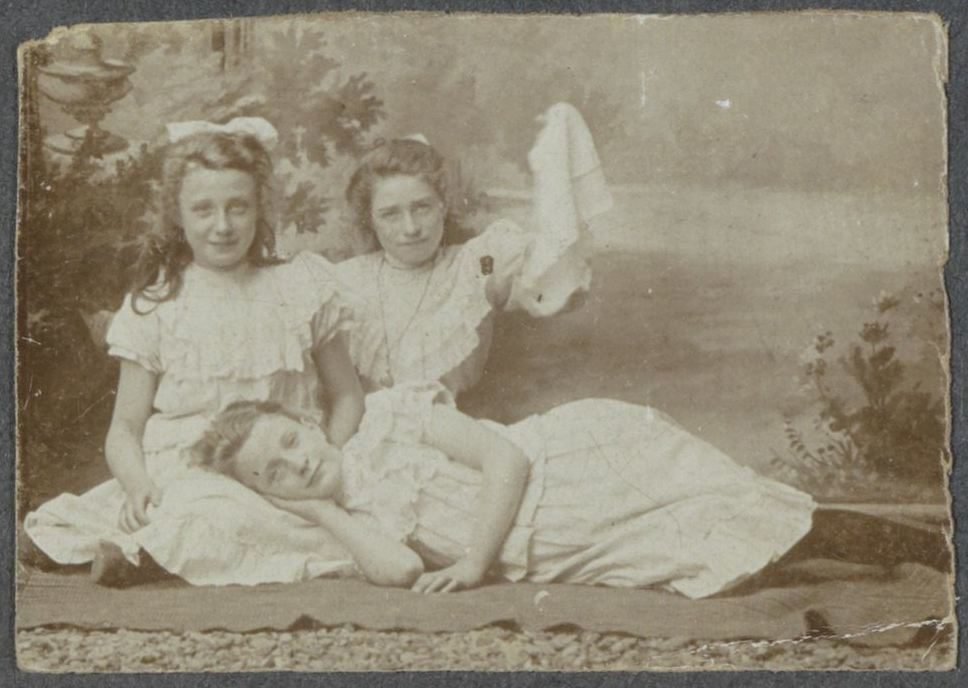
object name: photograph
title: Groepsportret van drie meisjes, mogelijk zussen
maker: Anonymous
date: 1920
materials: cardboard, paper, photographic support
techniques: collodion silver print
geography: netherlands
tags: studio requisites ~ photographer, historical persons, sisters (second degree family relationships), netherlands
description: Onderdeel van Fotoalbum met portretten vervaardigd door Nederlandse studio's waaronder automaatfoto's.